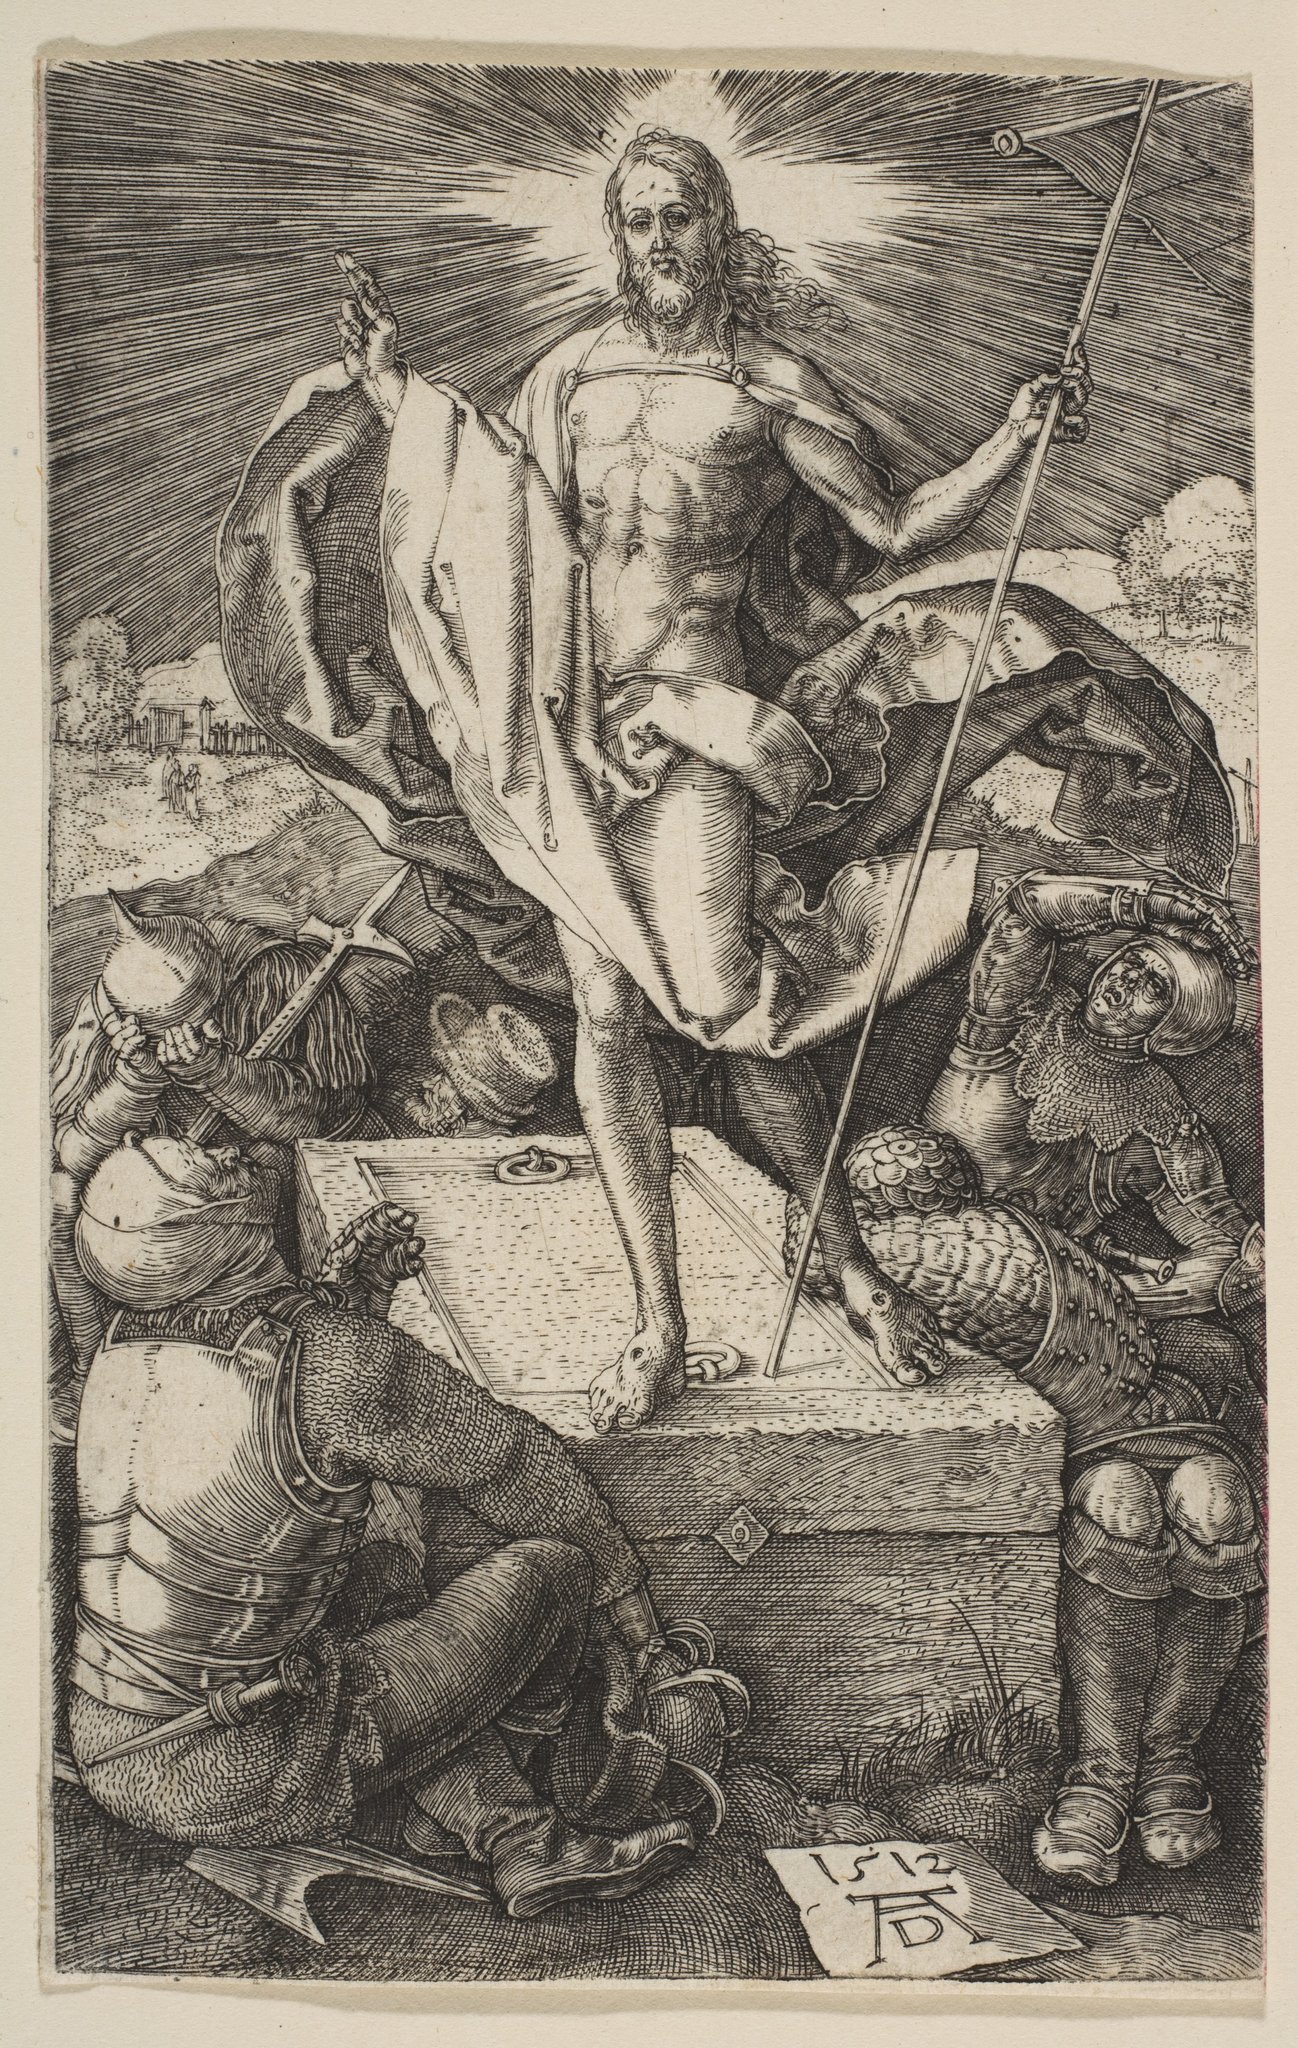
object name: print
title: The Resurrection, from "The Passion"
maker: albrecht dürer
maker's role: artist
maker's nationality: german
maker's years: 1471-1528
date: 1512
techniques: engraving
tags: soldiers,men,christ